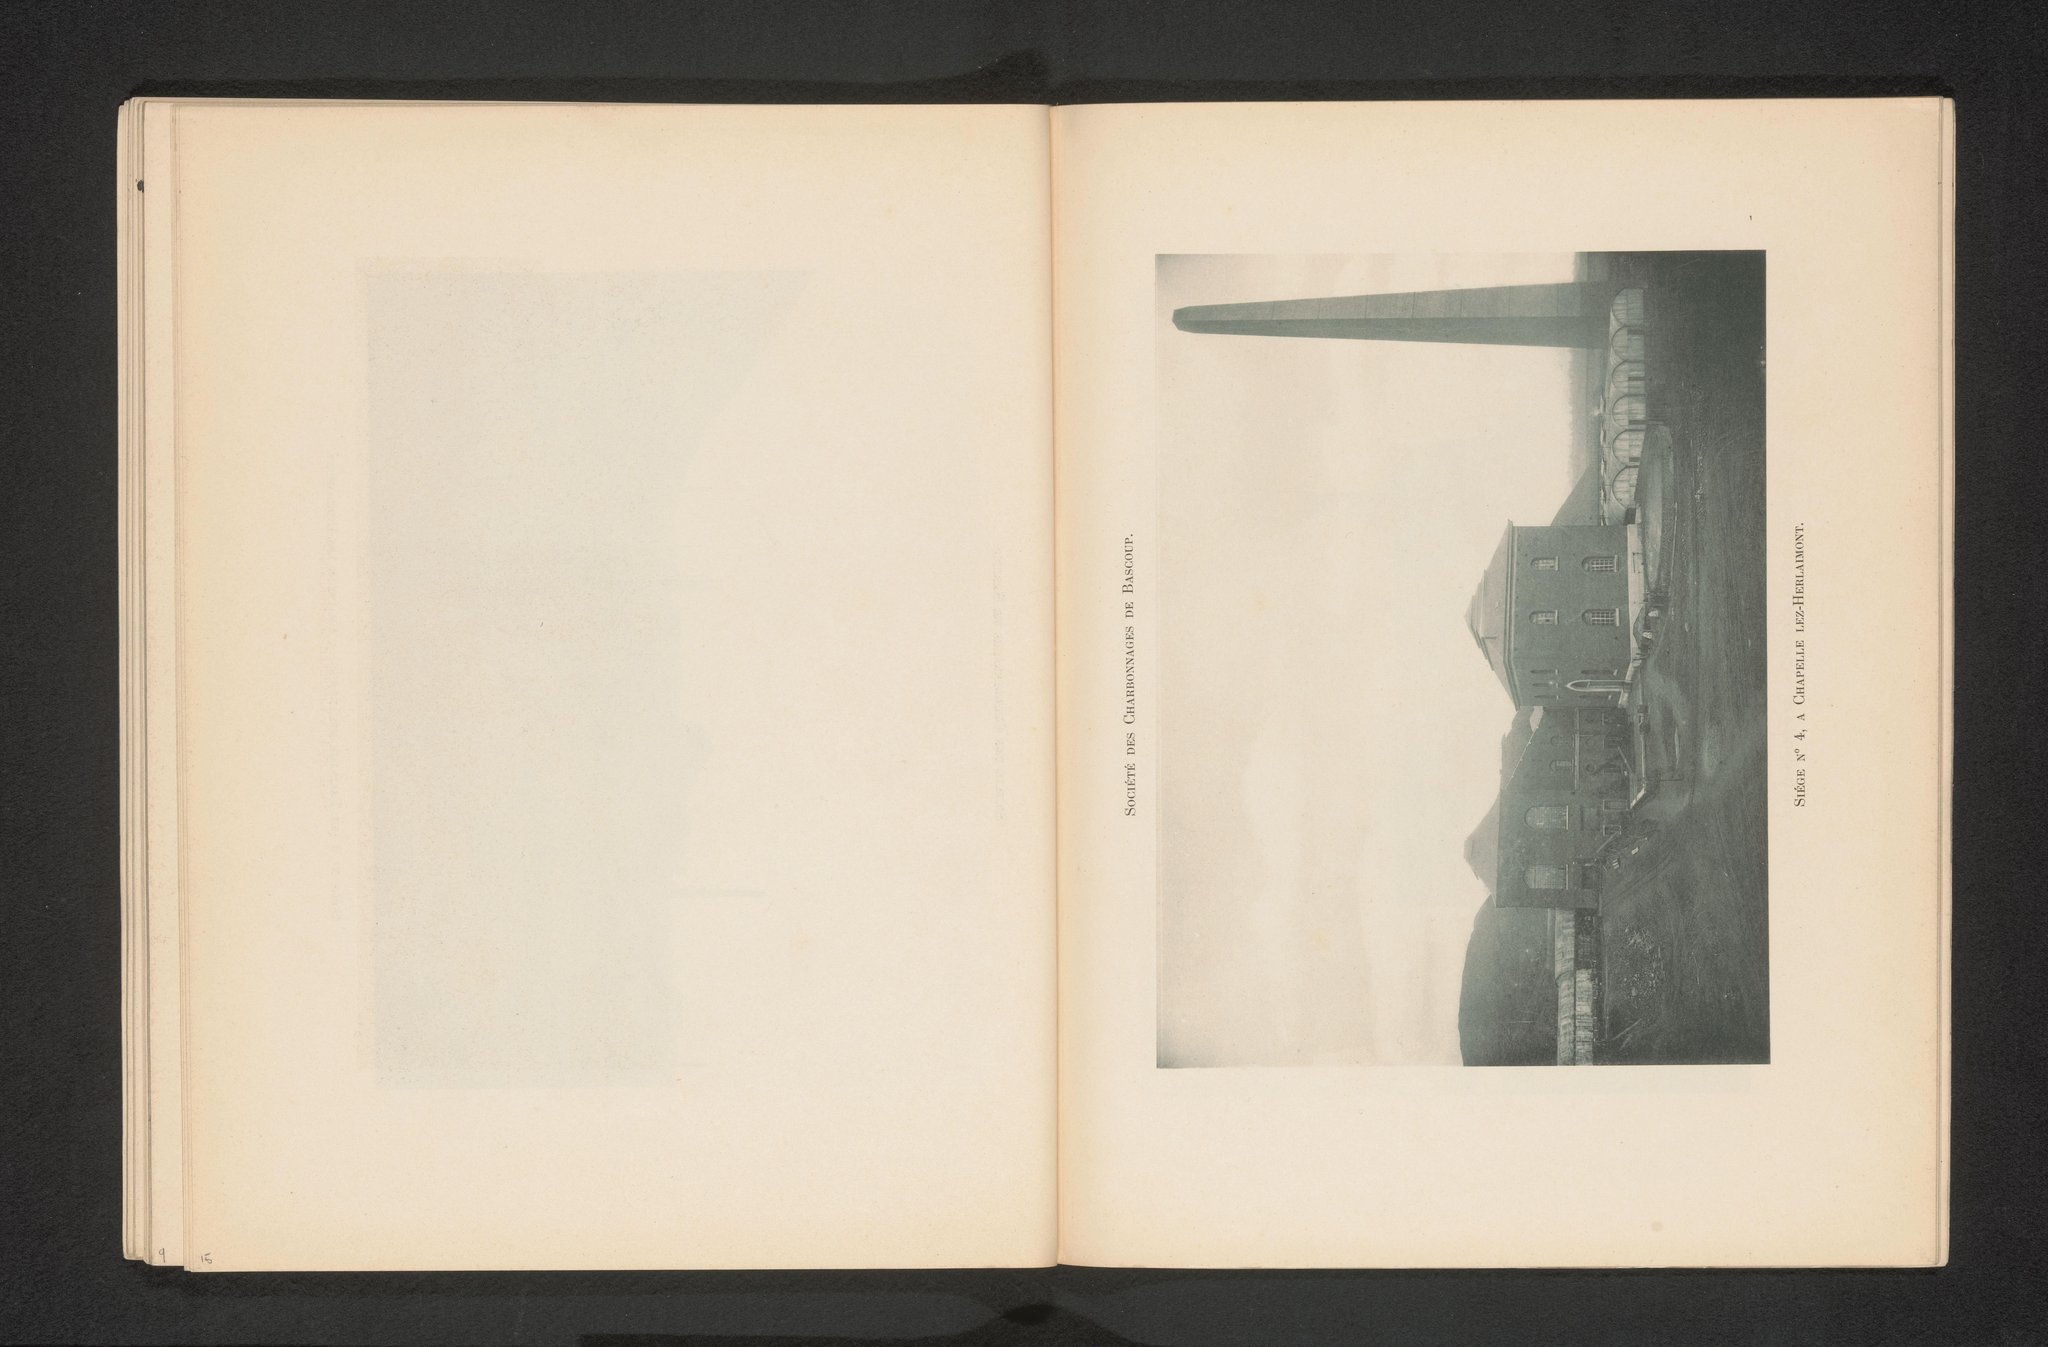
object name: page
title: Siége No 4, a Chapelle lez-Herlaimont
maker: Anonymous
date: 1895-1900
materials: paper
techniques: photograph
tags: factory in landscape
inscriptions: inscription: ‘Société des Charbonnages de Mariemont’